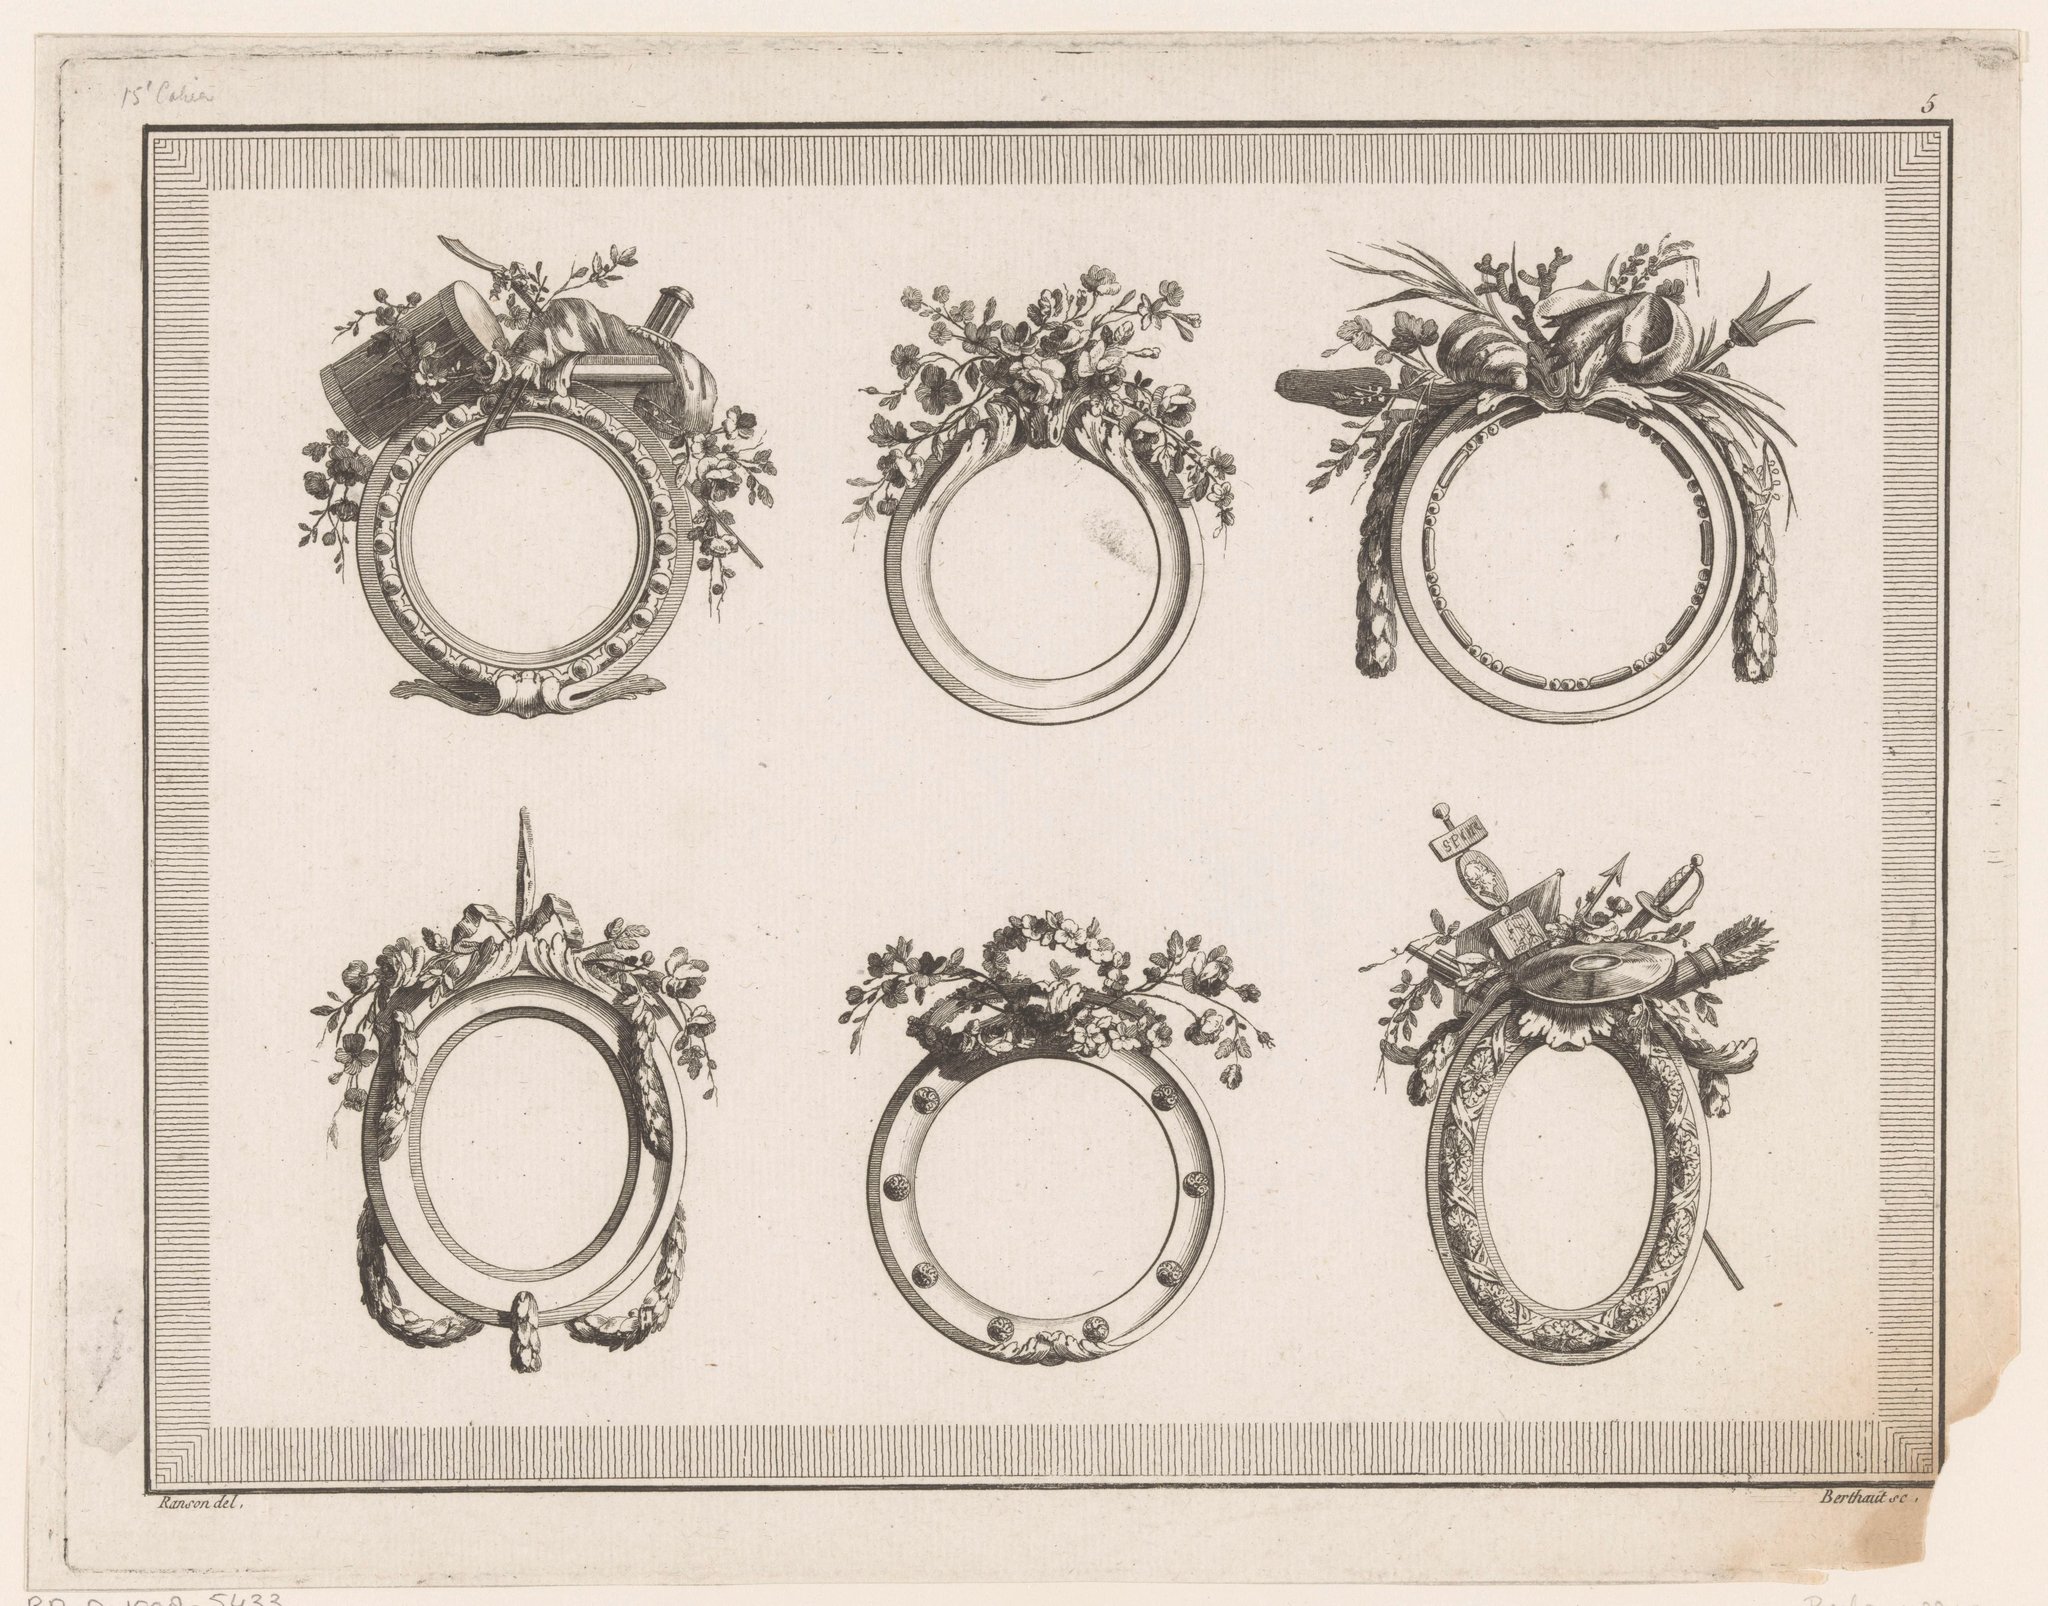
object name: print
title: Medaillons met muziekinstrumenten en wapens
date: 1778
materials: paper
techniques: etching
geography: paris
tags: musical instruments; group of musical instruments, trophy, i.e.: decorative arrangement of symbolic or typical objects ~ ornament, weapons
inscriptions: collector's mark: Lugt 2228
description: Zes medaillons. Links boven met trommel en doedelzak. Midden boven, links- en midden onder met bloemen. Rechts onder met schild en wapens.